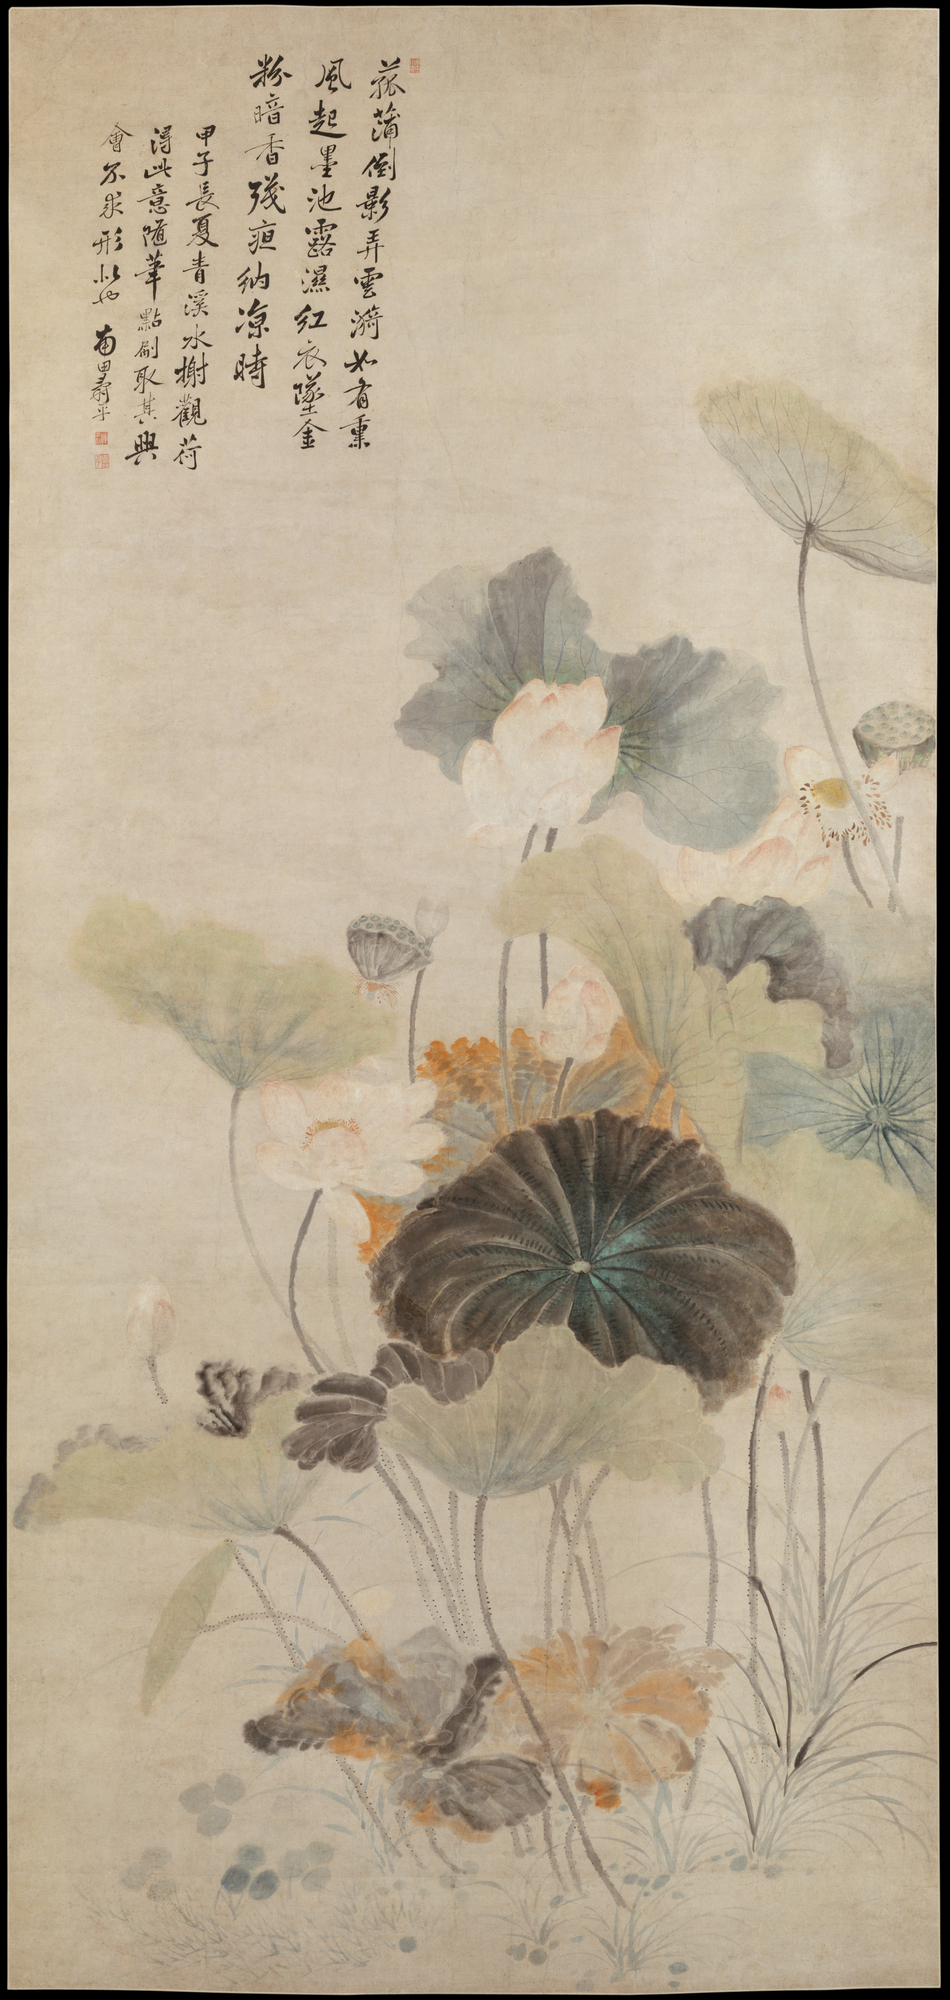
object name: hanging scroll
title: Lotuses on a summer evening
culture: chinese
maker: yun shouping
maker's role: artist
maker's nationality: chinese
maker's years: 1633-1690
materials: ink, paper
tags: lotuses